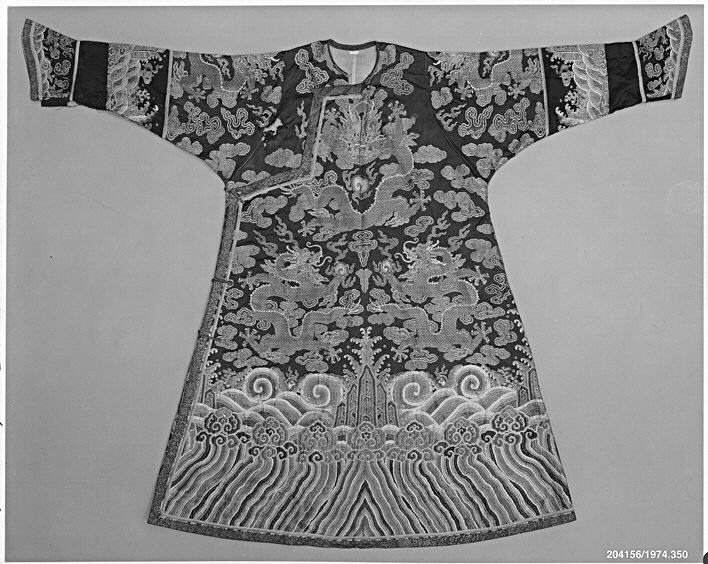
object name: woman's imperial state robe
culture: chinese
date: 1662-1722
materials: metal thread, silk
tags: dragons